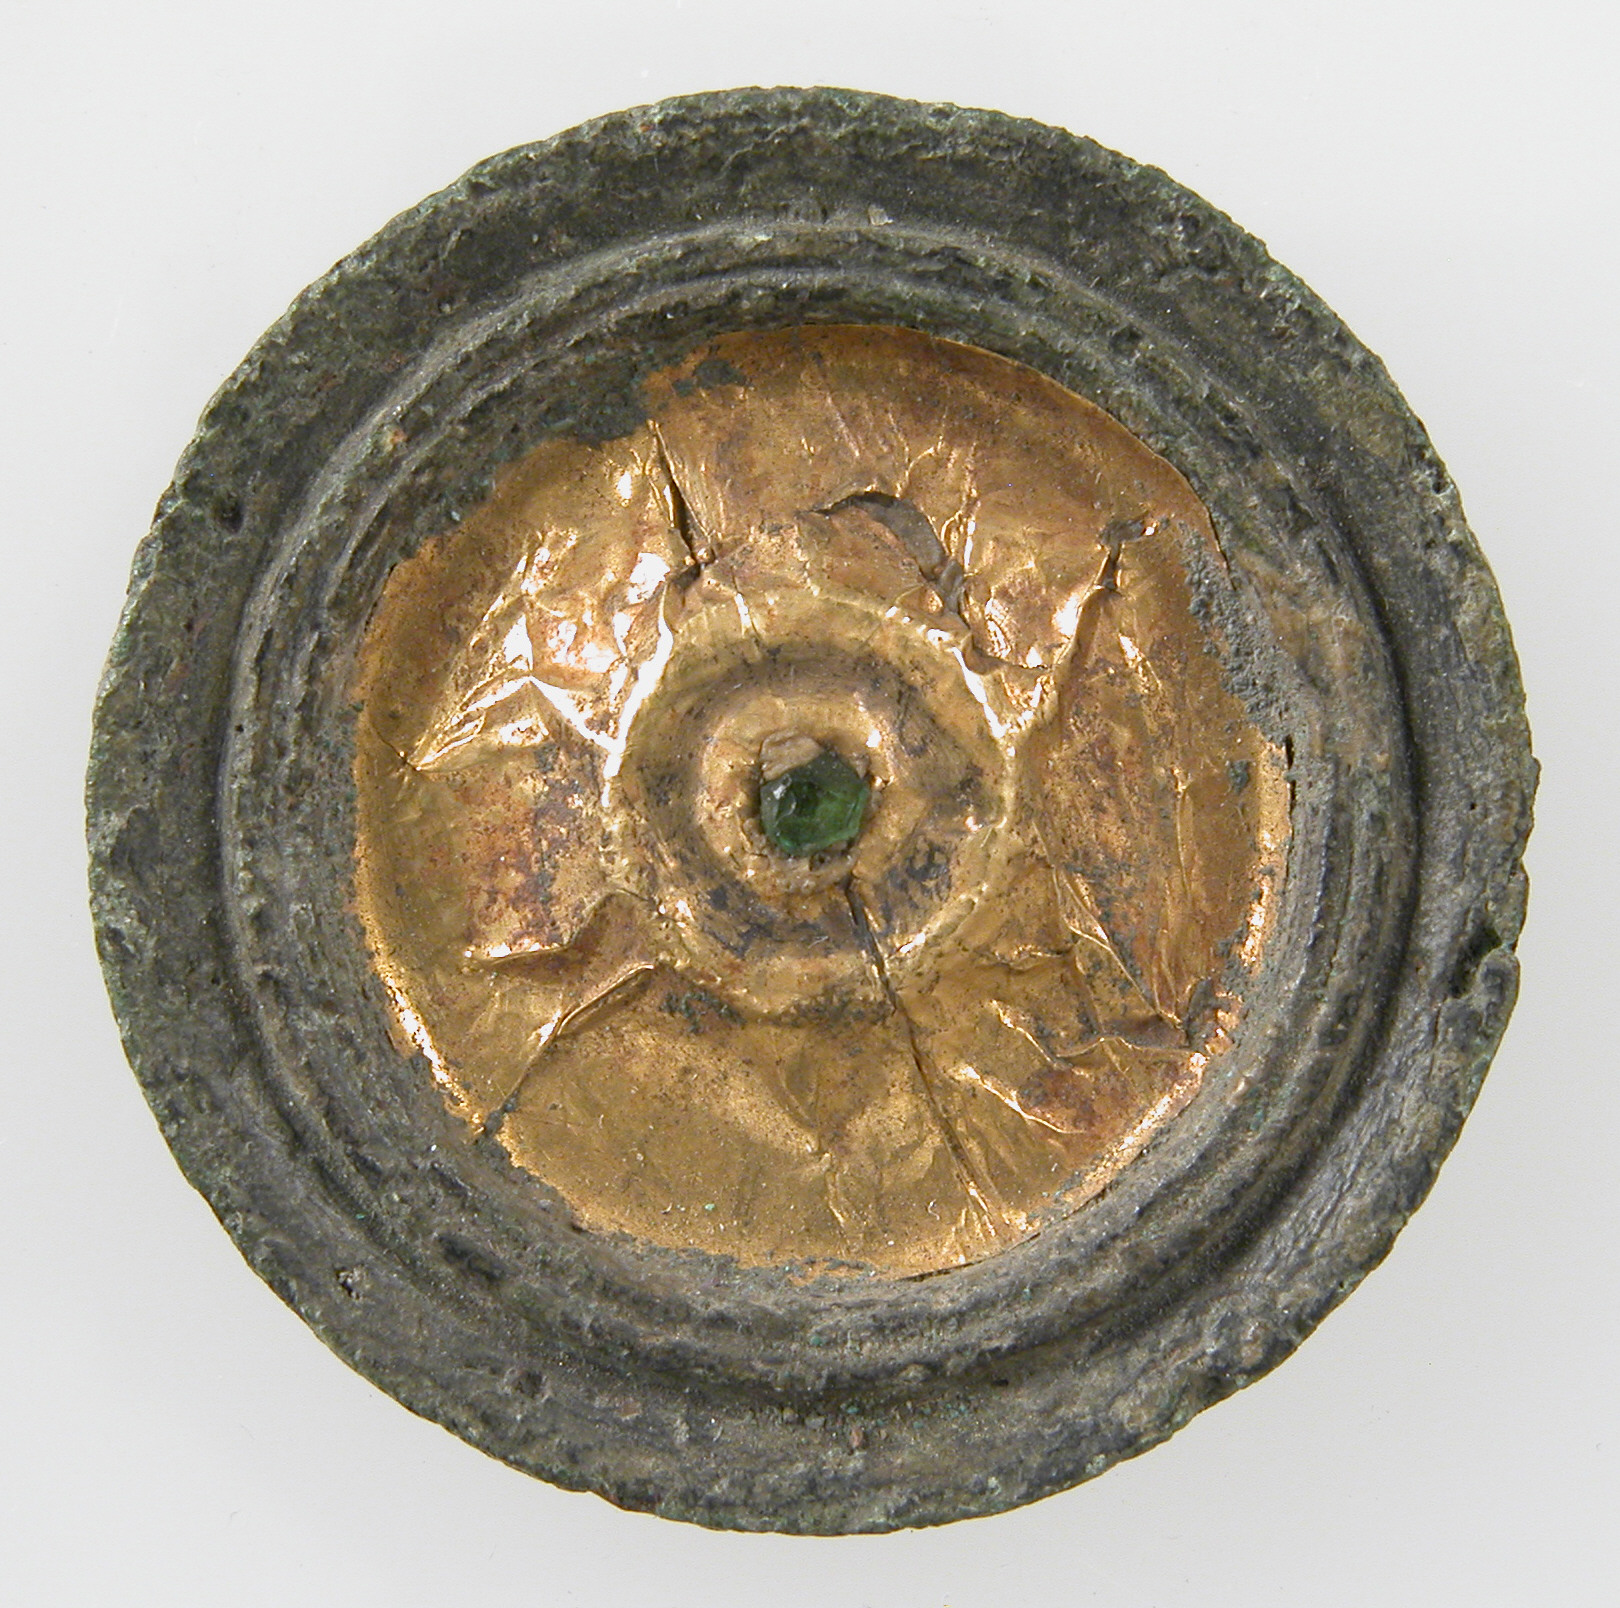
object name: brooch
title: Disk Brooch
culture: frankish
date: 500-700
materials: copper alloy, glass, gold, paste